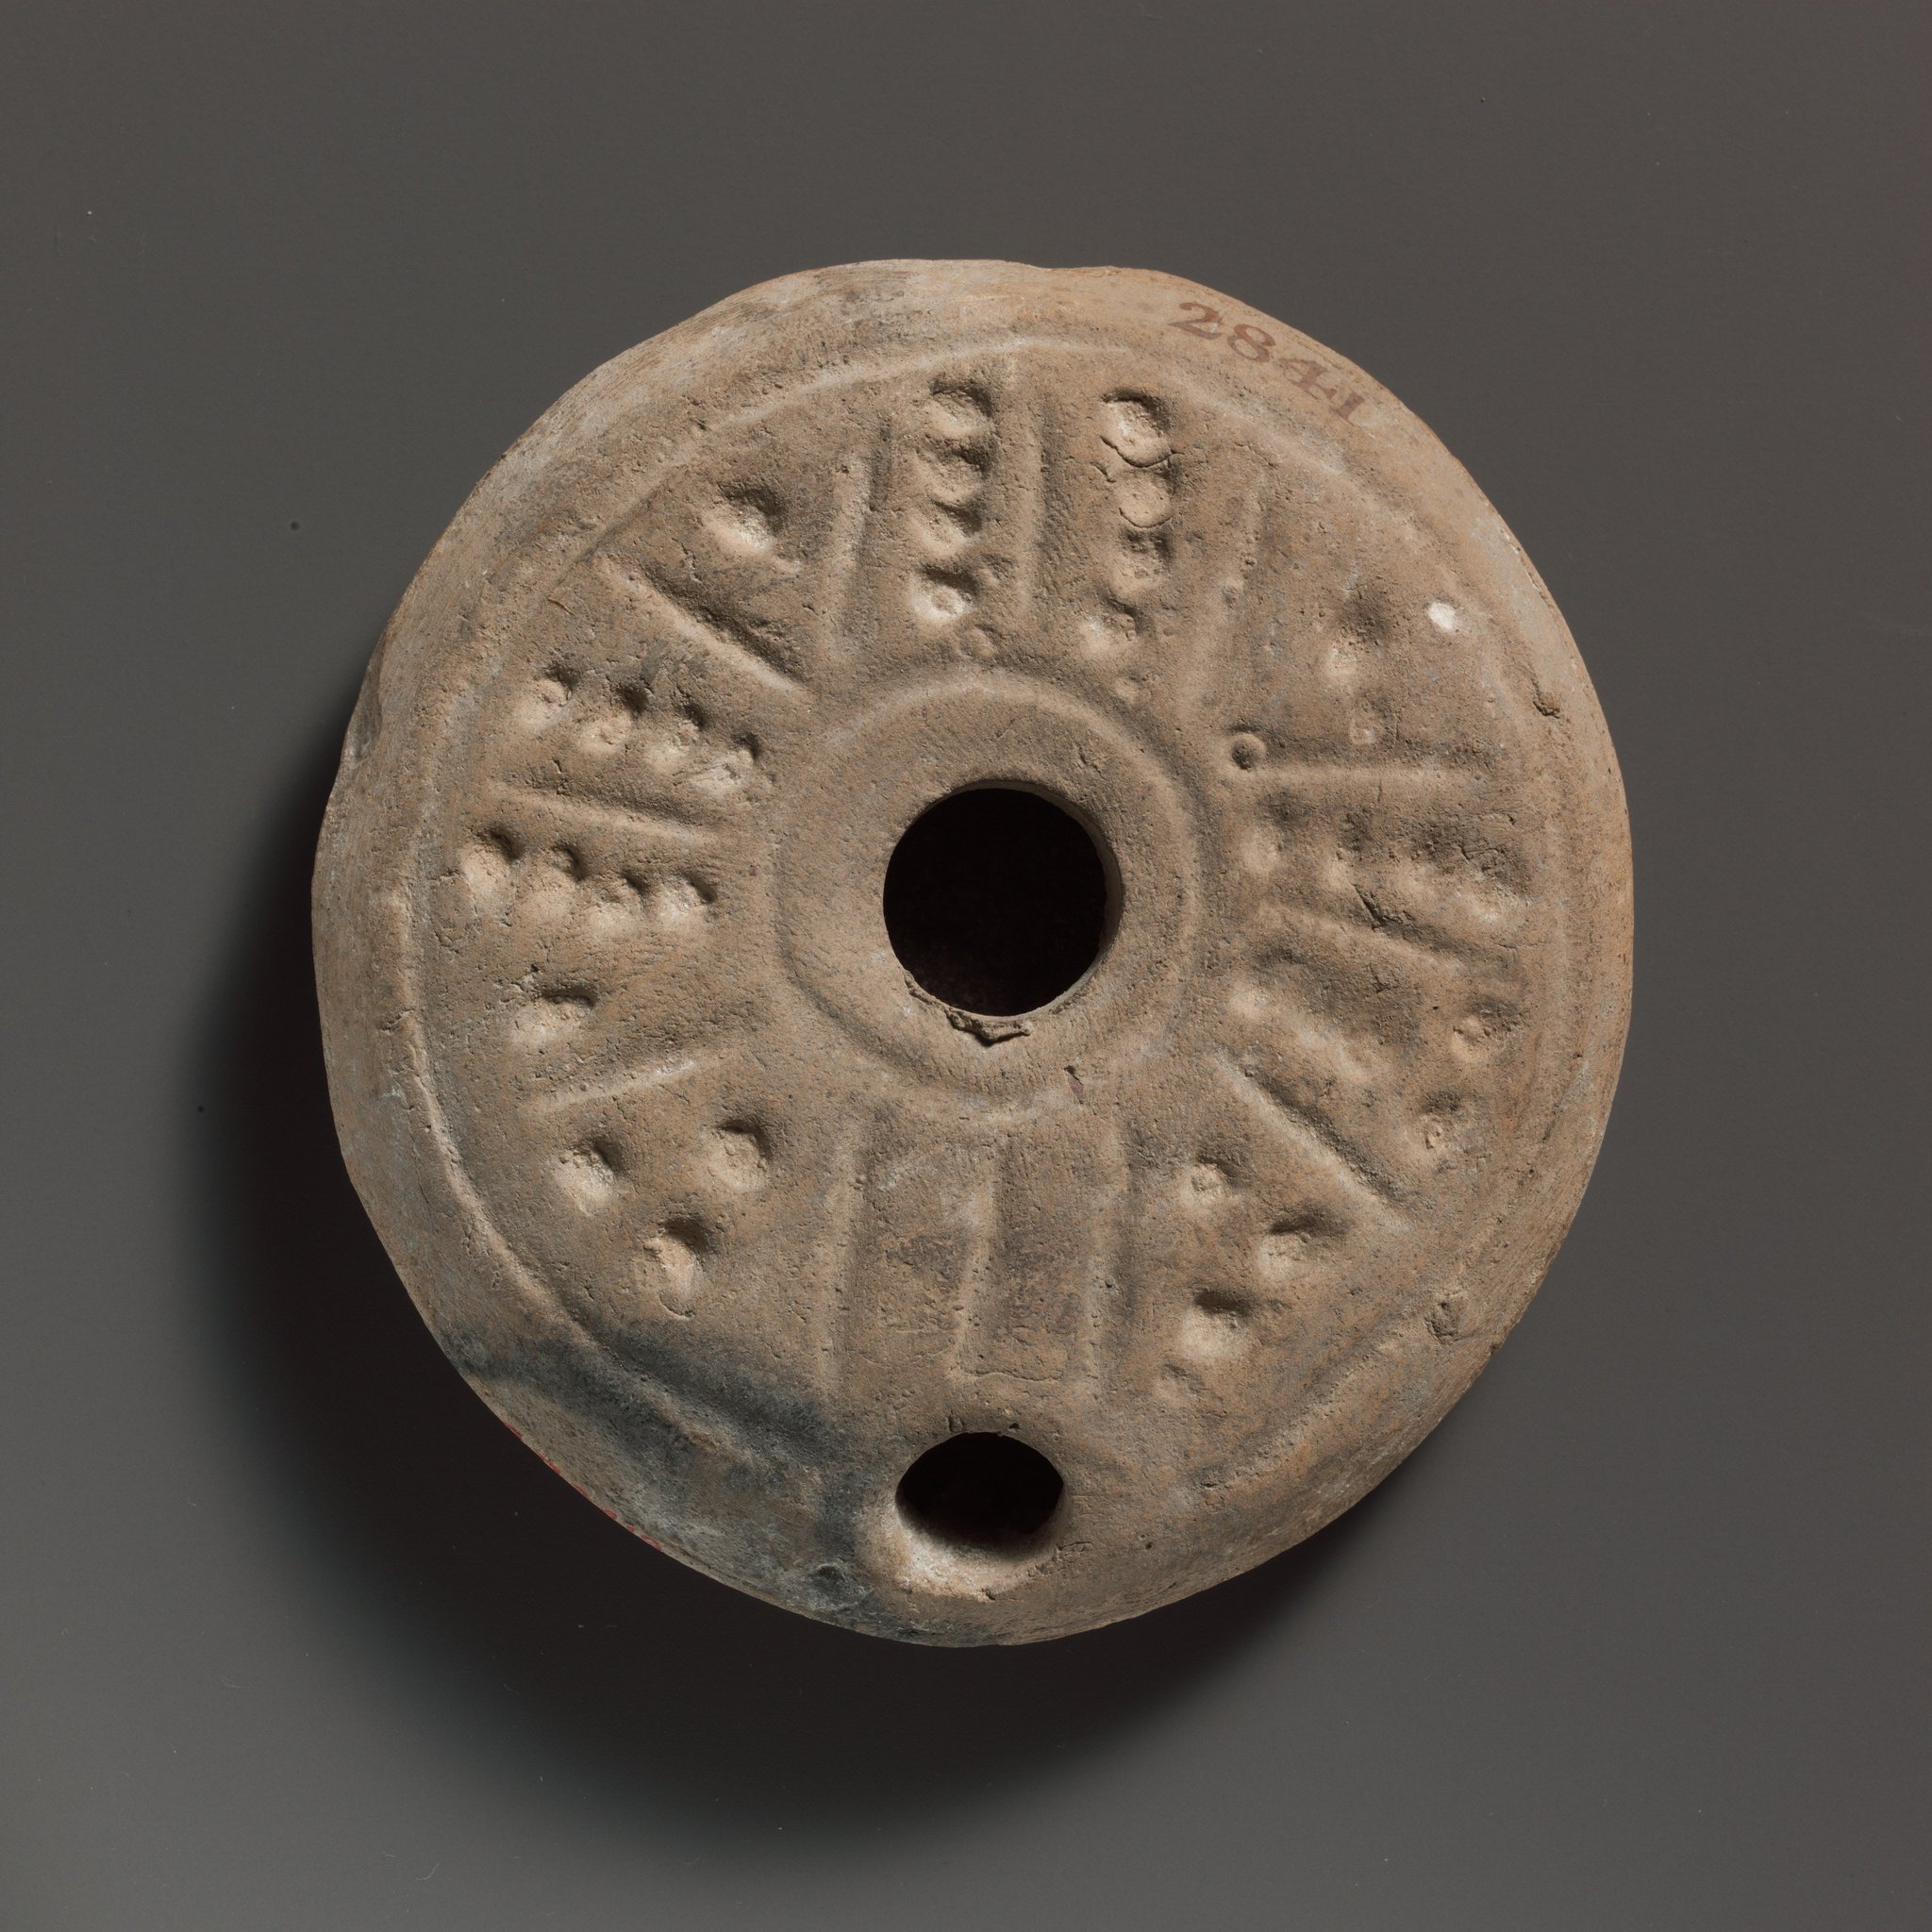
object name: lamp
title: Terracotta oil lamp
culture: roman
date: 467-600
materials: terracotta